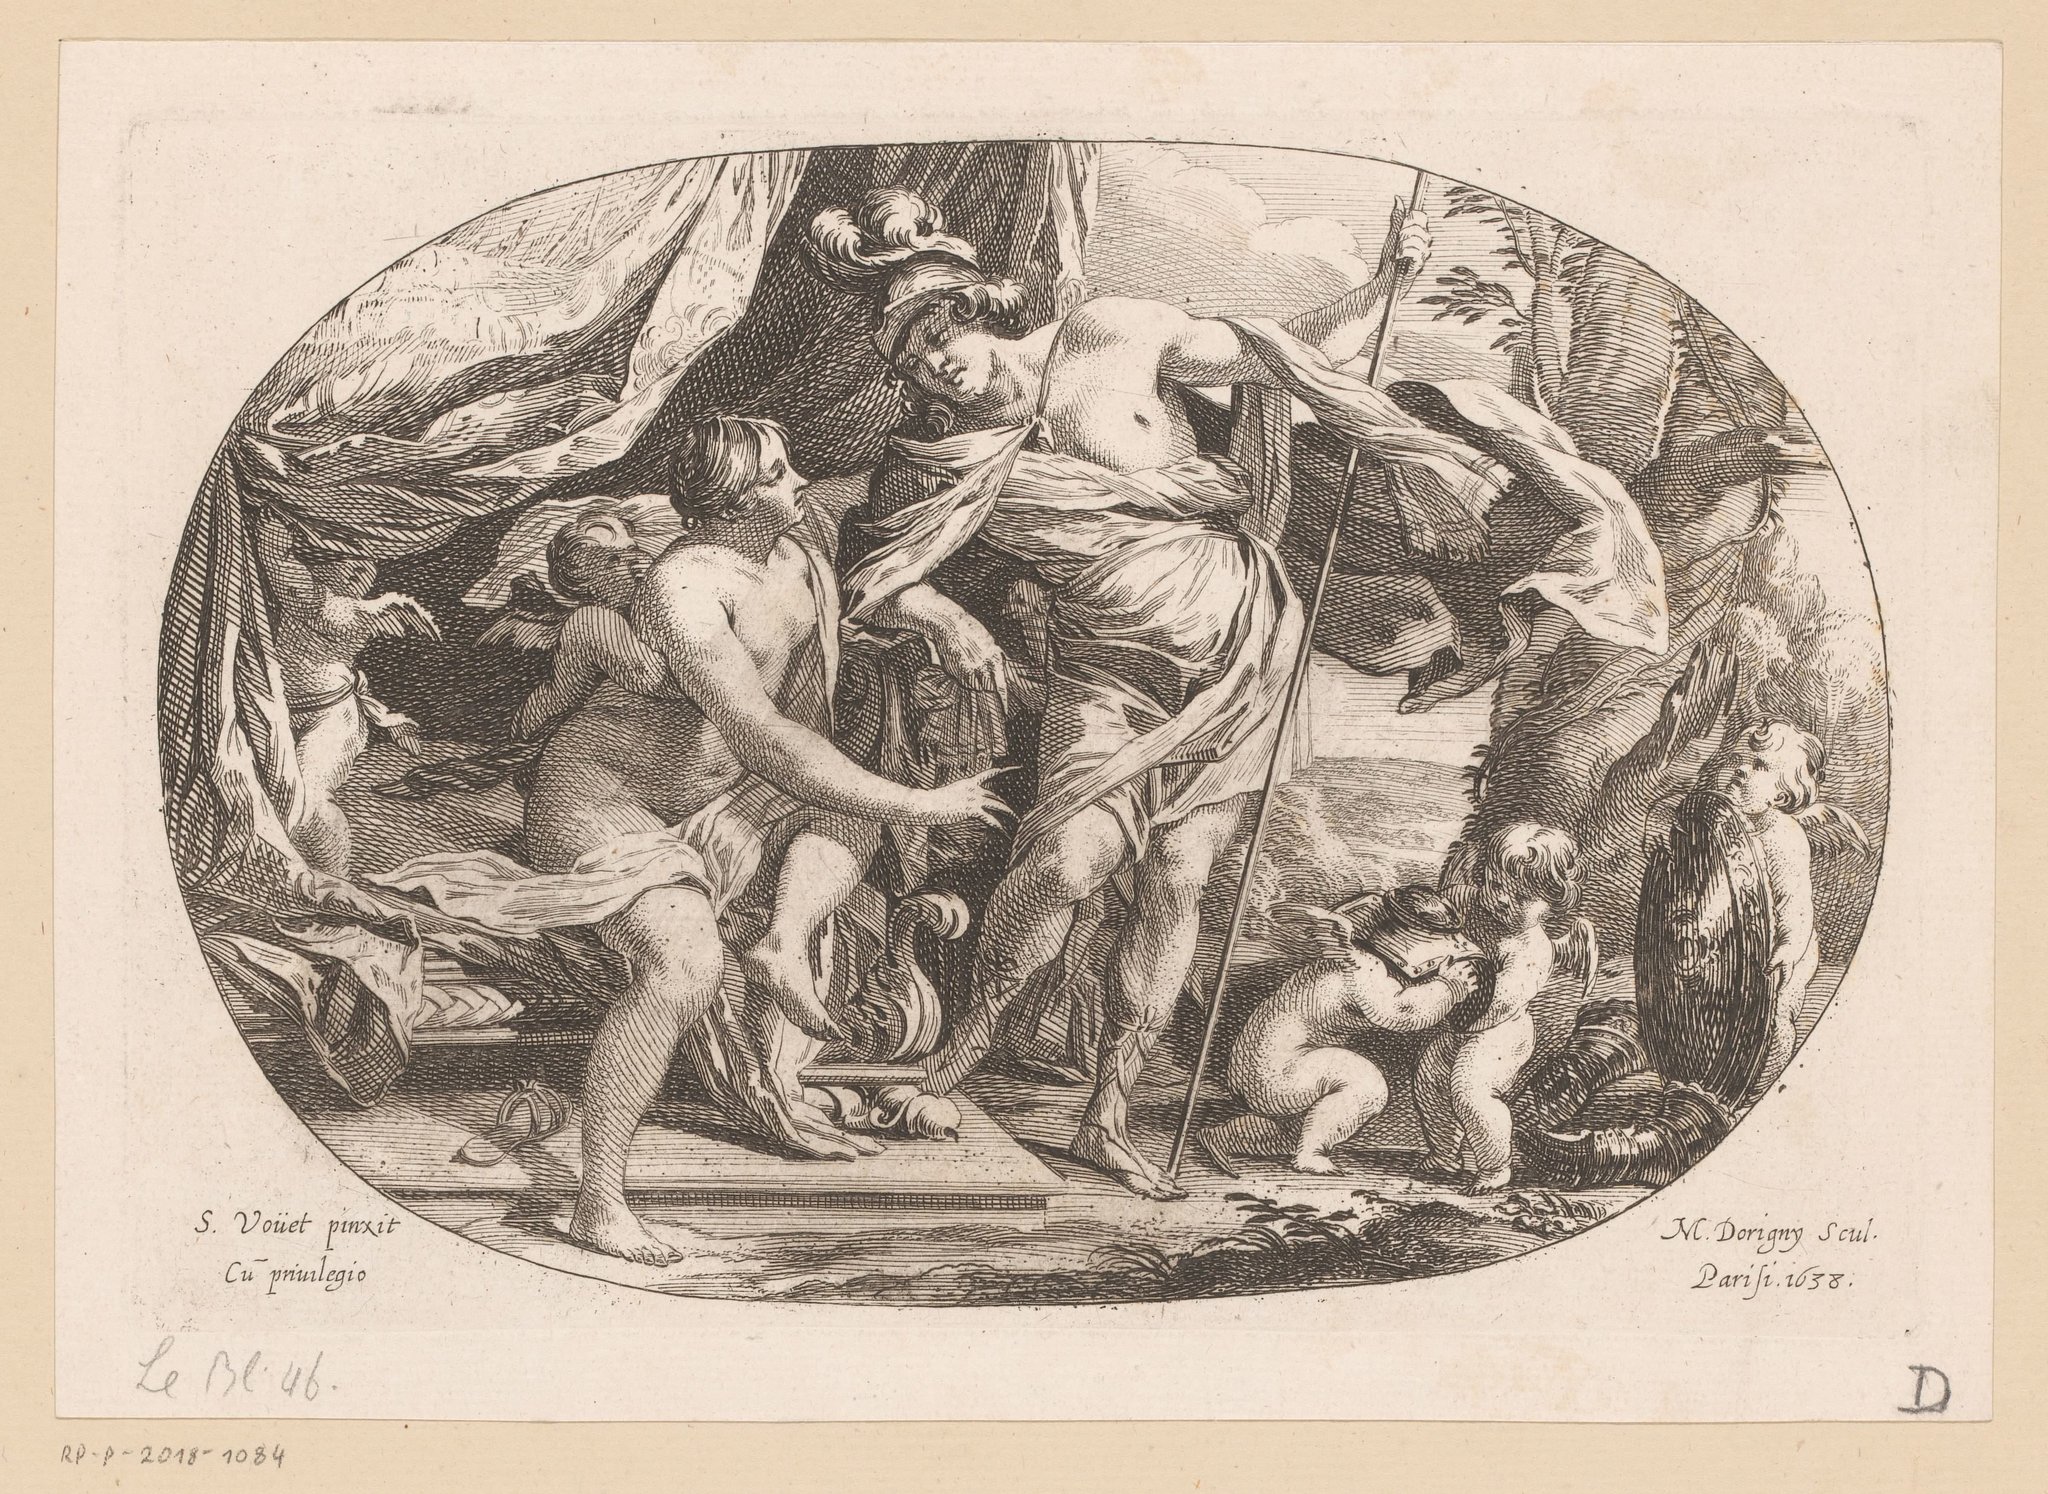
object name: print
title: Mars en Venus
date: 1638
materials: paper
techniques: engraving, etching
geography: paris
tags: mars and venus as lovers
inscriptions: collector's mark: Lugt 2228